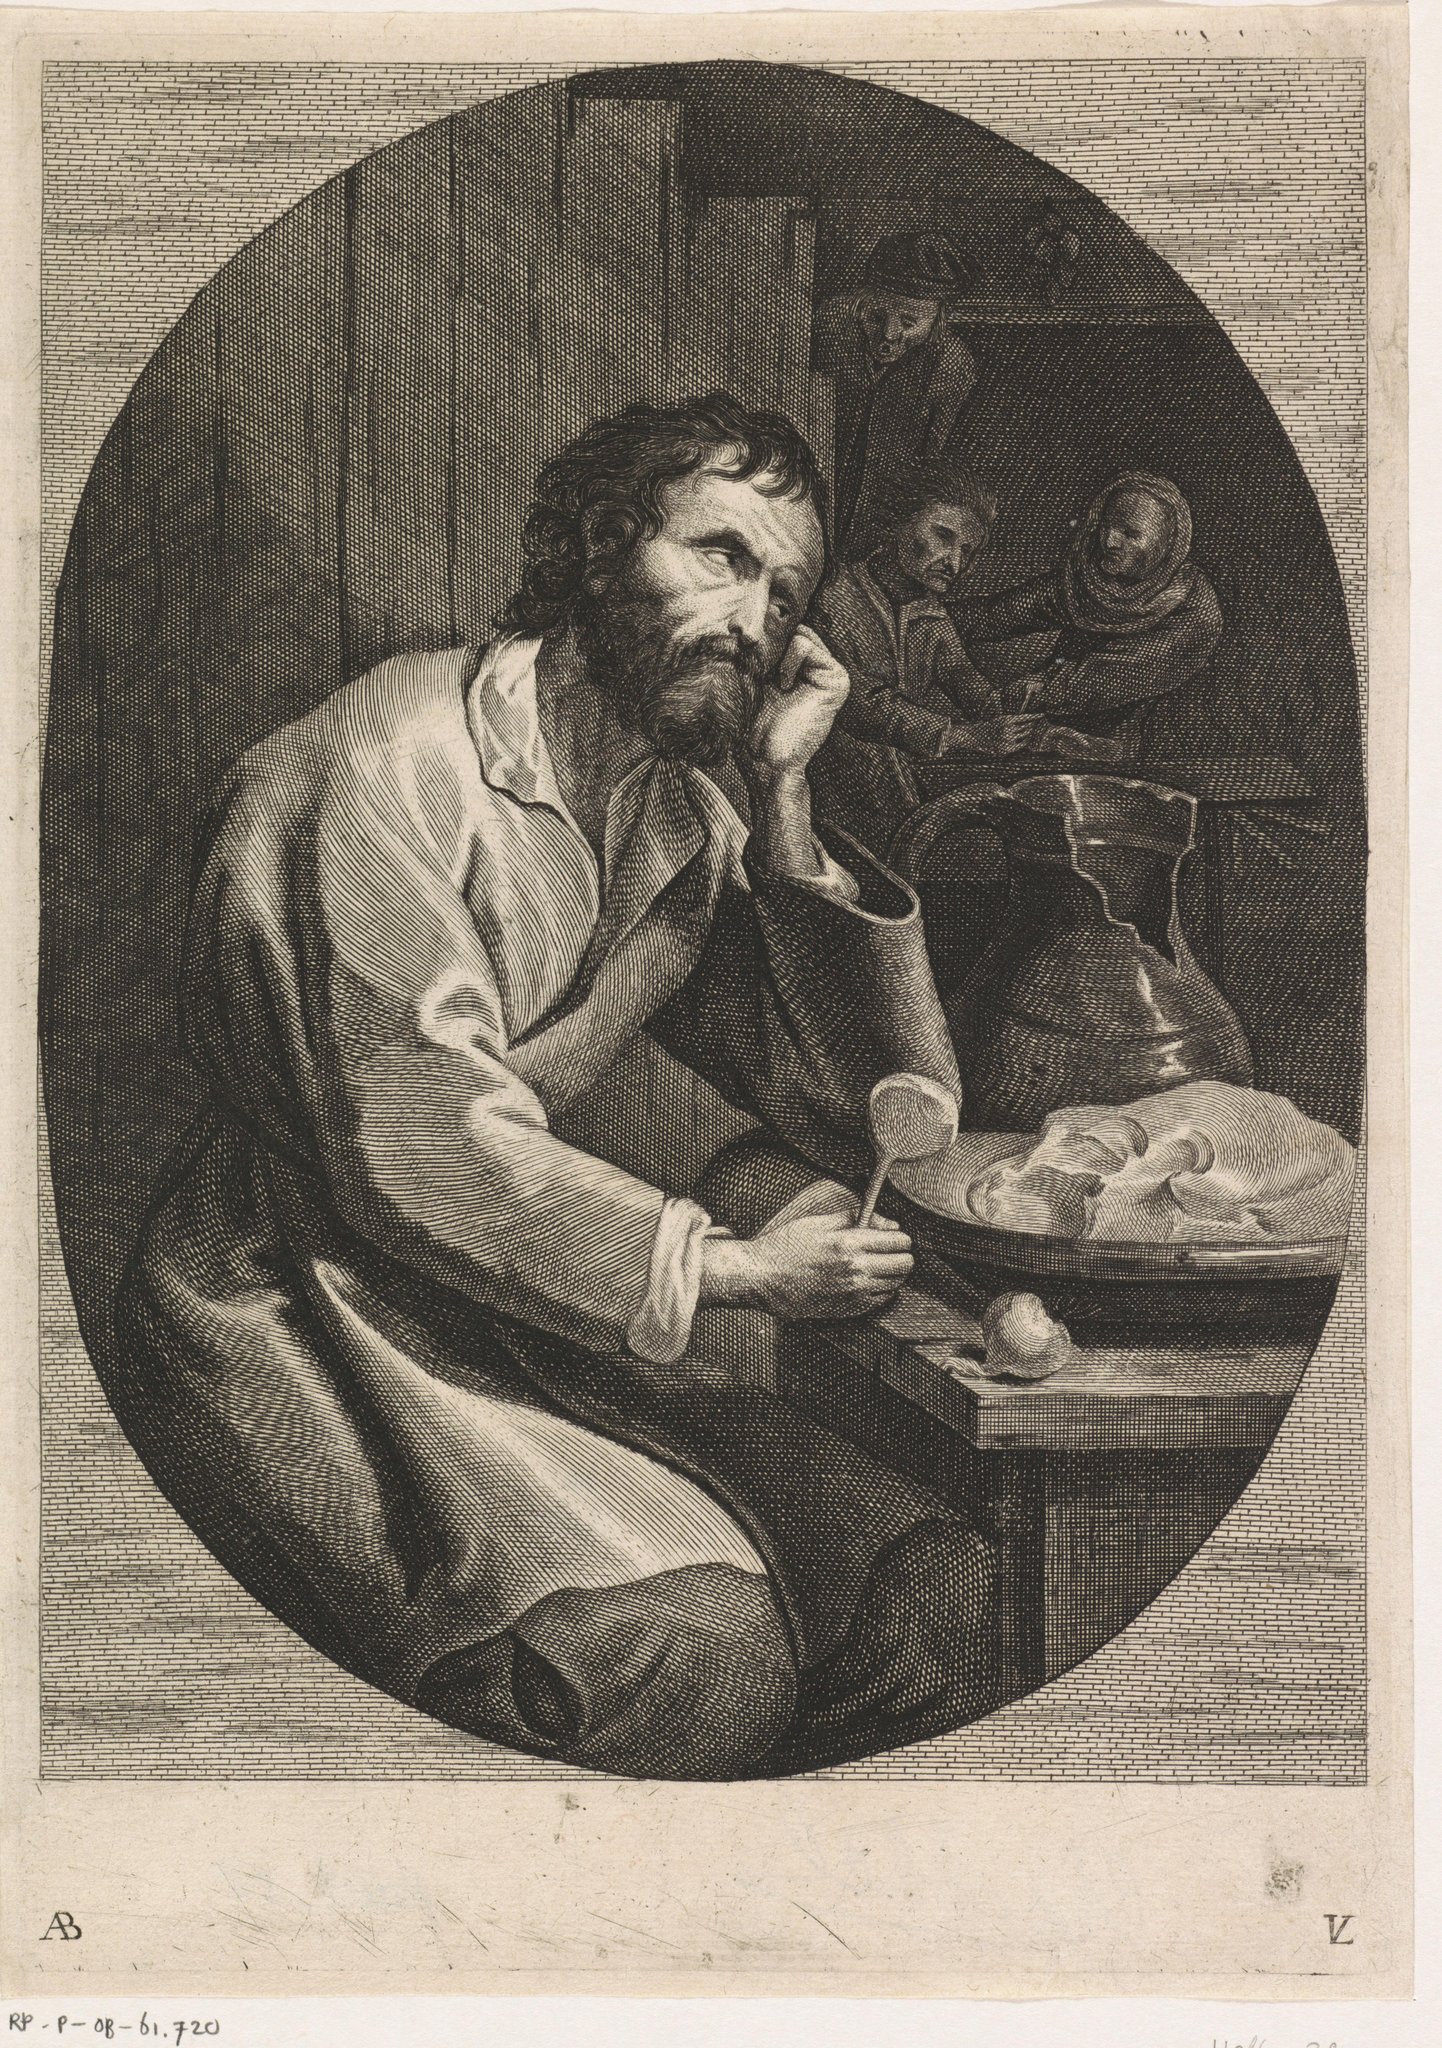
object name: print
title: Blinde man aan de maaltijd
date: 1651-1652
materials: paper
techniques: engraving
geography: antwerp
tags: container of ceramics: jar, jug, pot, vase (+ broken, damaged), blind, blindness, spoon, head held in the hand(s), with elbows leaning on an elevation or on the knees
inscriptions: collector's mark: Lugt 240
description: In een vertrek zit een boer aan een tafel waarop hij zijn hand met lepel, laat rusten. Op de tafel staan een schaal met eten en een gebroken kruik. Op de achtergrond een vrouw en twee mannen.